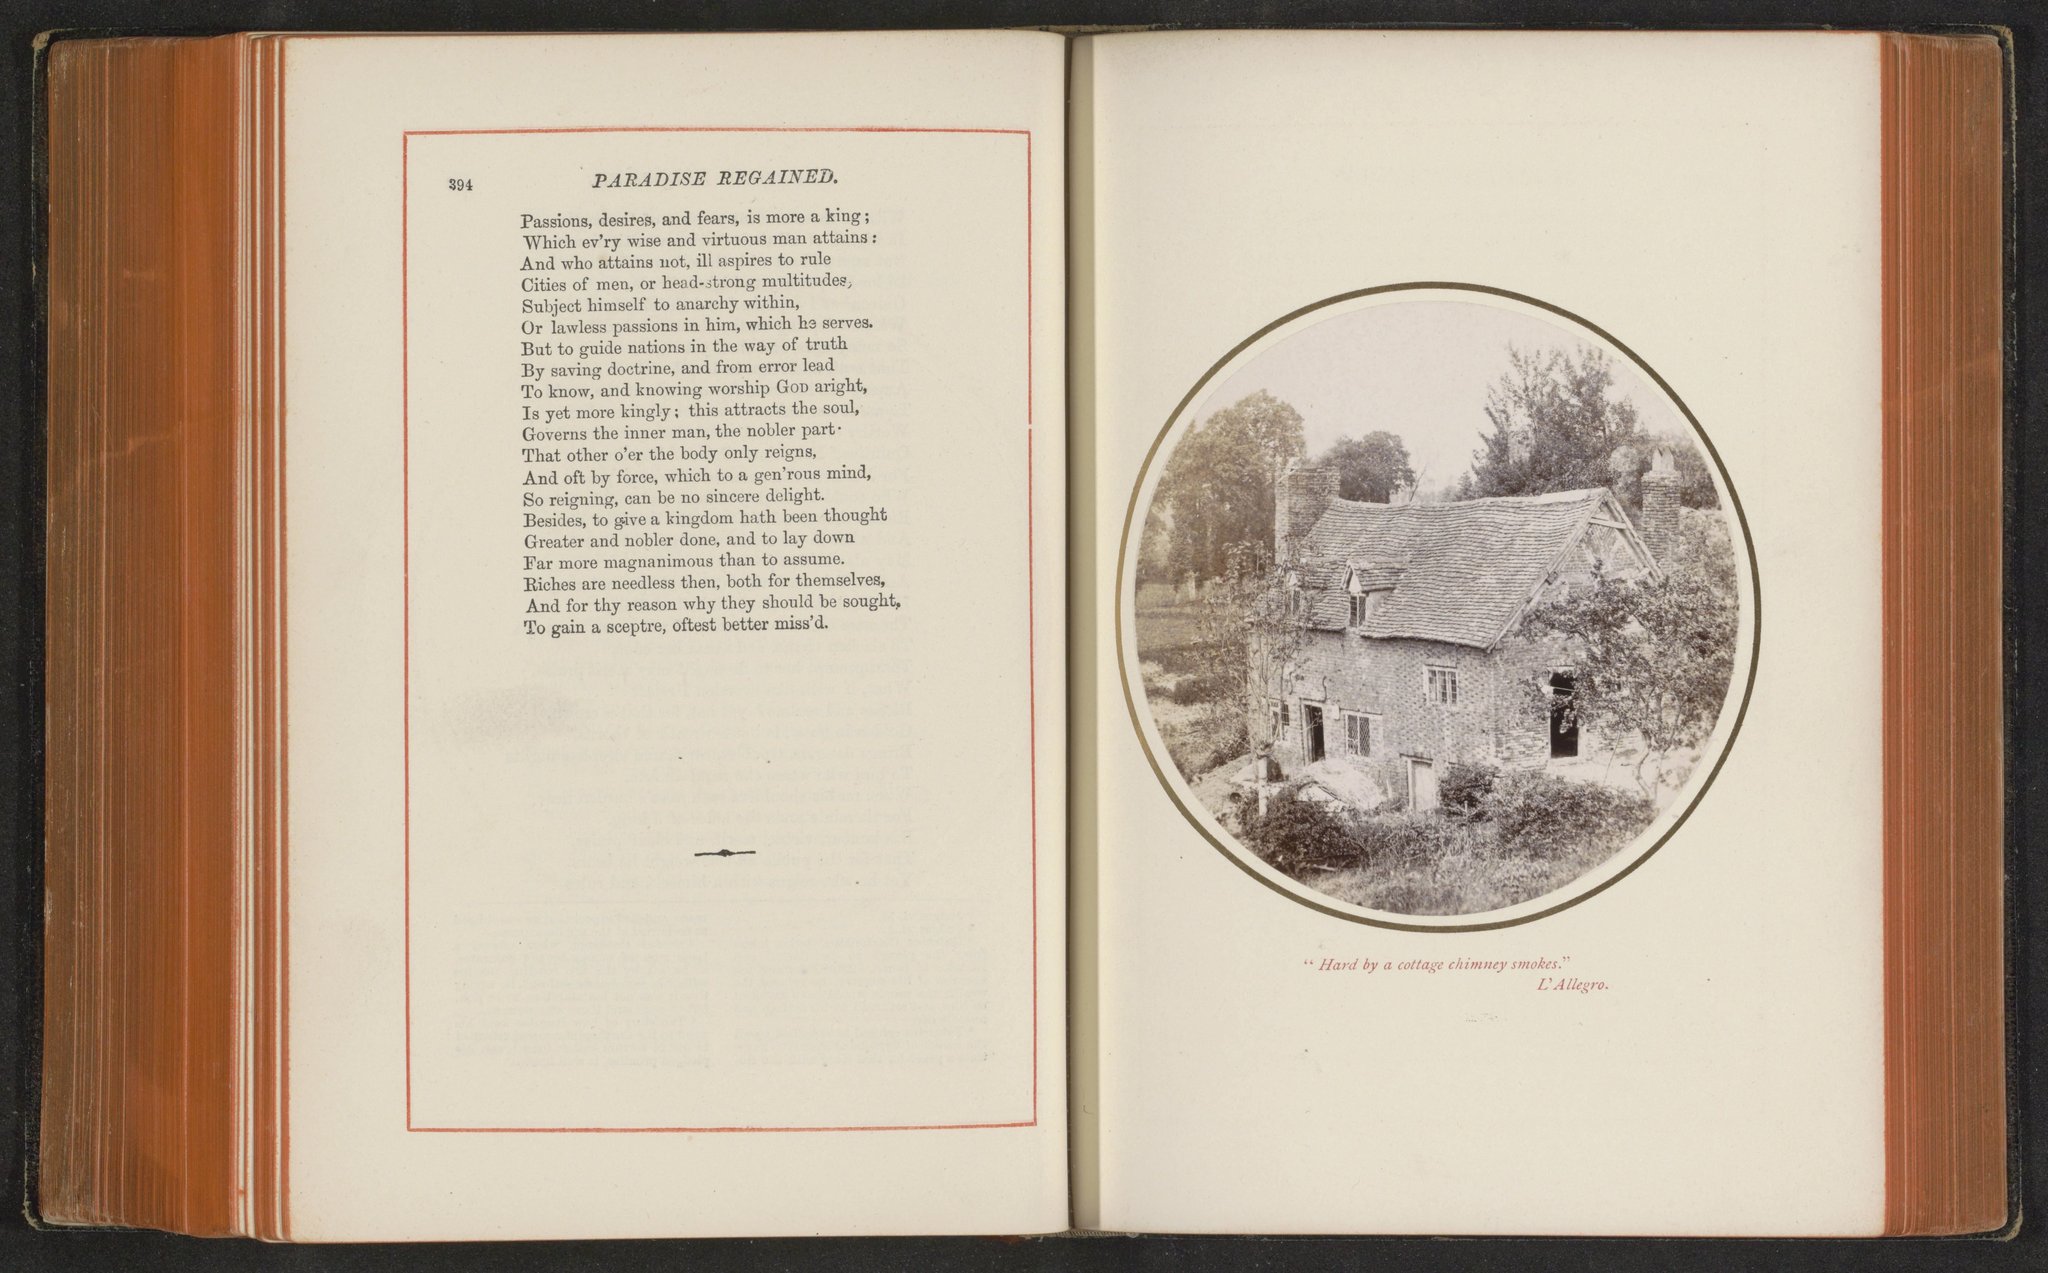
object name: page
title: Gezicht op een landhuis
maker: deswall vaughan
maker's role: fotograaf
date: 1875-1885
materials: photographic support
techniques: albumen print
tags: rural housing, e.g. country-house, villa, cottage, façade (of house or building)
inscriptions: inscription: ‘" Hard by a cottage chimney smokes." L'Allegro.’